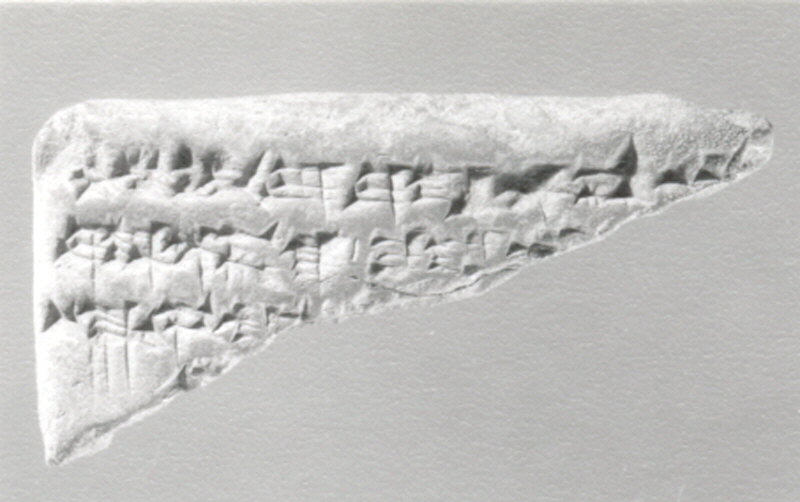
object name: cuneiform tablet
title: Cuneiform tablet: fragment of Lugal-e, tablet 7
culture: parthian or seleucid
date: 400-1 BCE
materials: clay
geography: mesopotamia